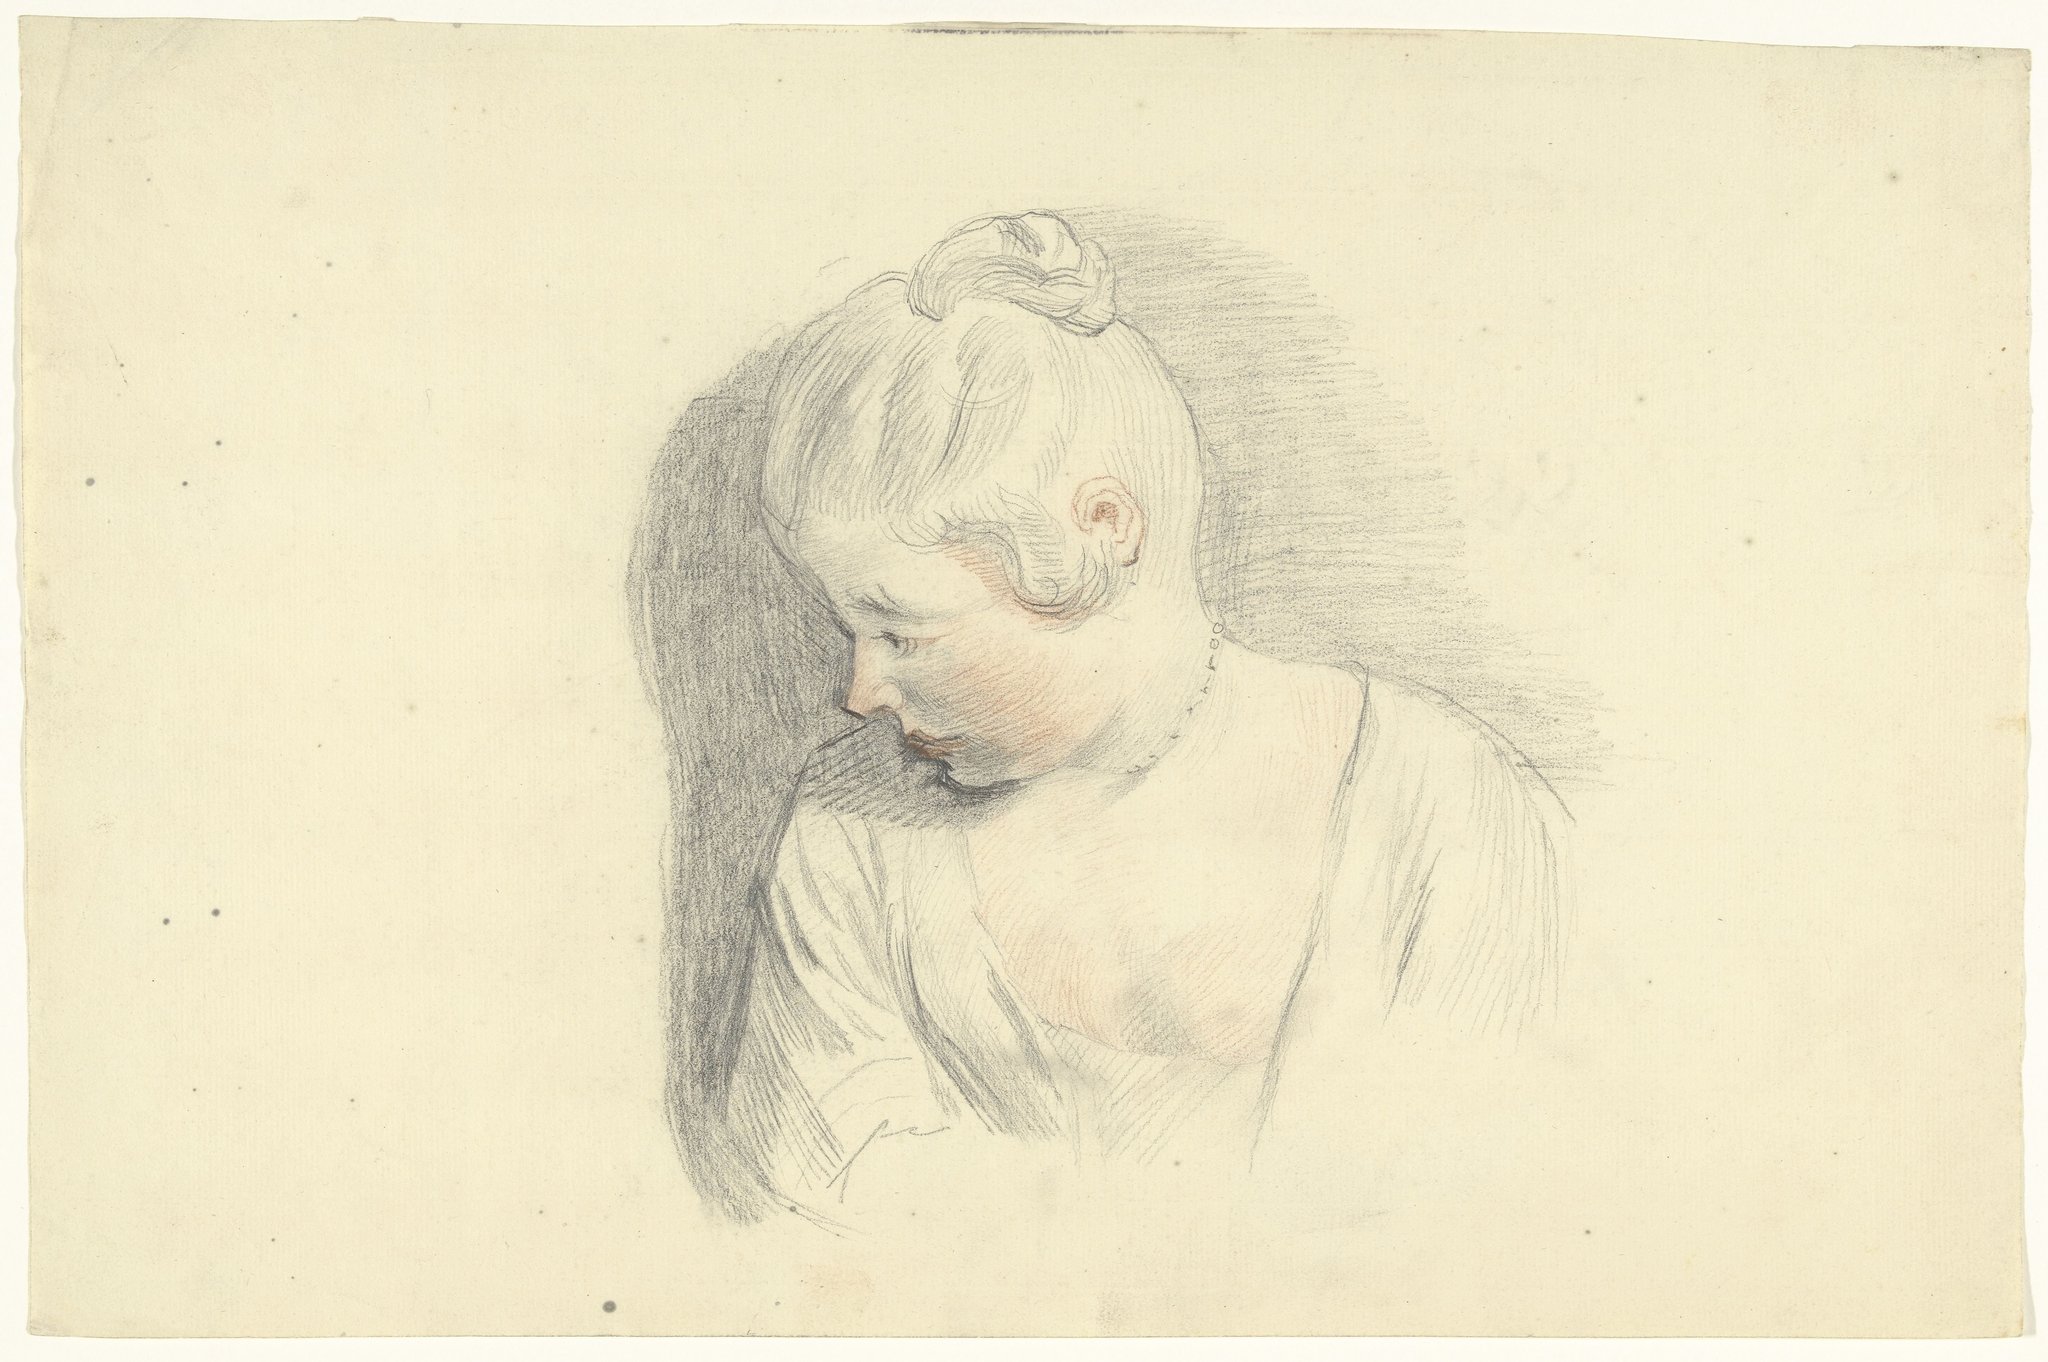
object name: drawing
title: Buste van vrouw, naar links omlaag ziend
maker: Anonymous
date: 1700-1800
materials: chalk, paper, pencil